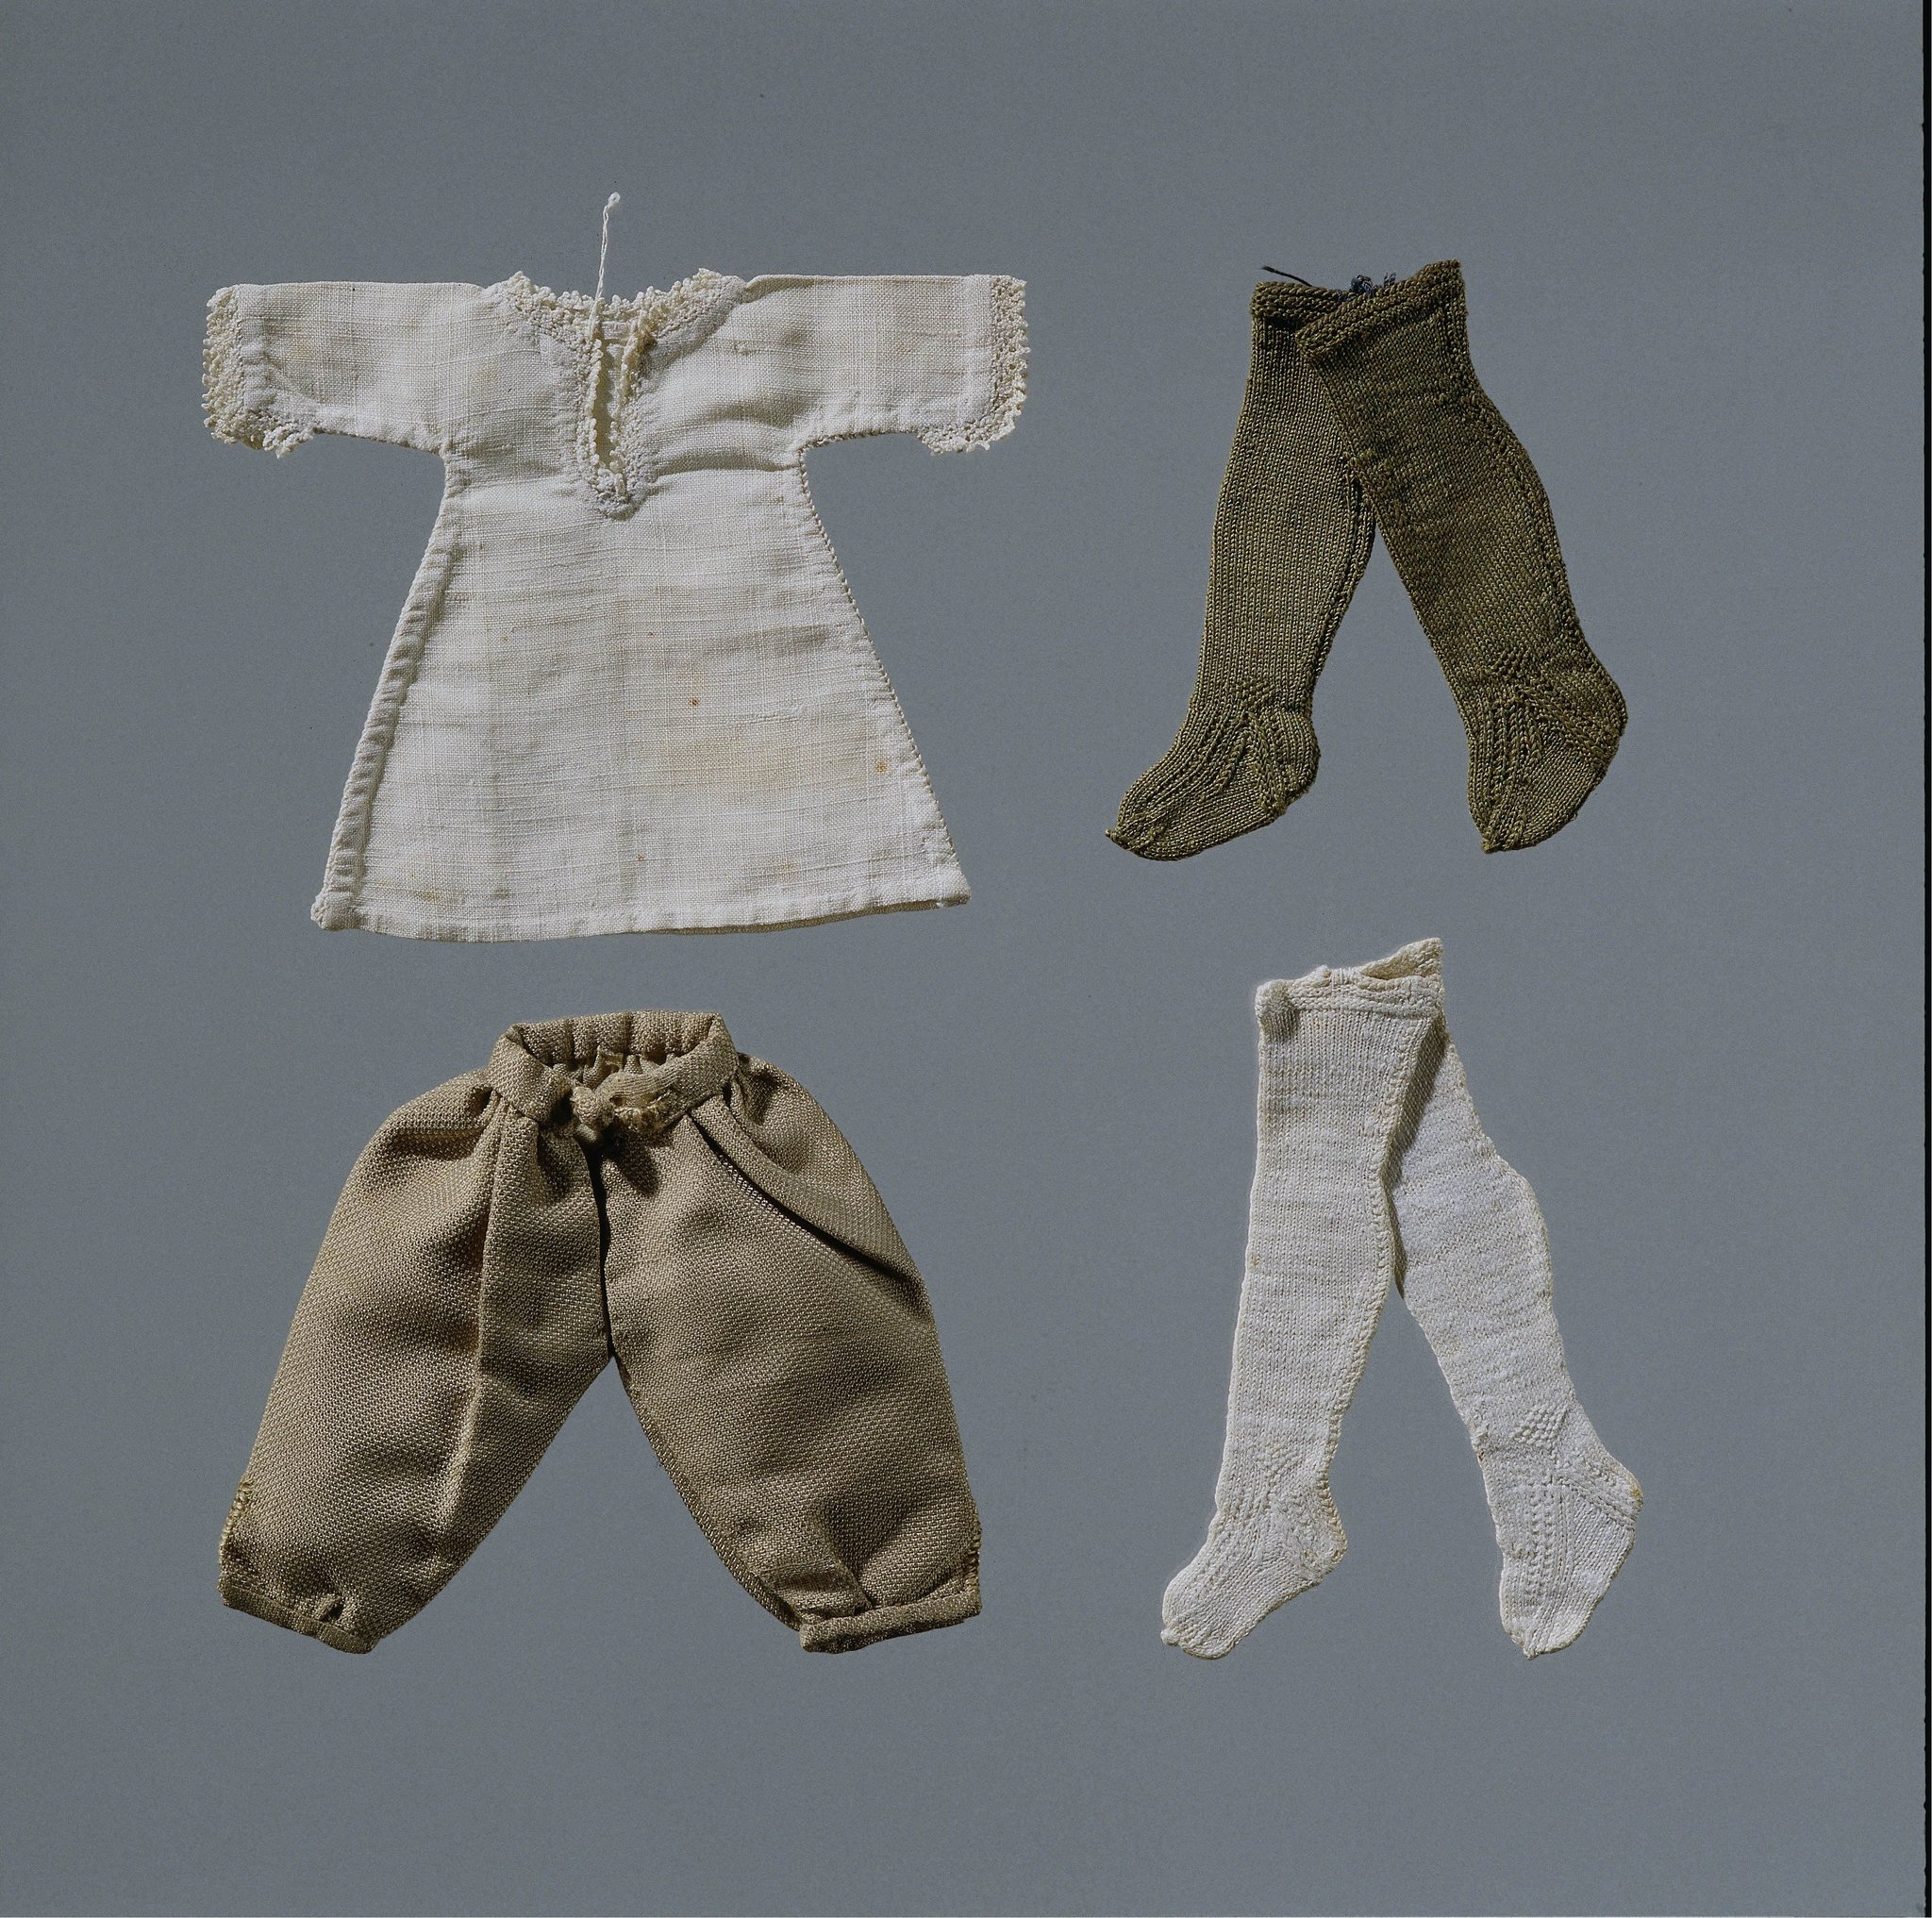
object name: miniature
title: Broek, van beige zijde, poffend model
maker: Anonymous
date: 1690-1710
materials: silk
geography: amsterdam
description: Broek van beige zijde met een crème zijden voering. Poffend model, aangerimpeld aan een taille band met gefestoneerd knopsgat en knoopje van stof. Eén kruisnaad vormt een split. Pijpen eveneens aangerimpeld aan bandje en met gefestoneerde splitjes.